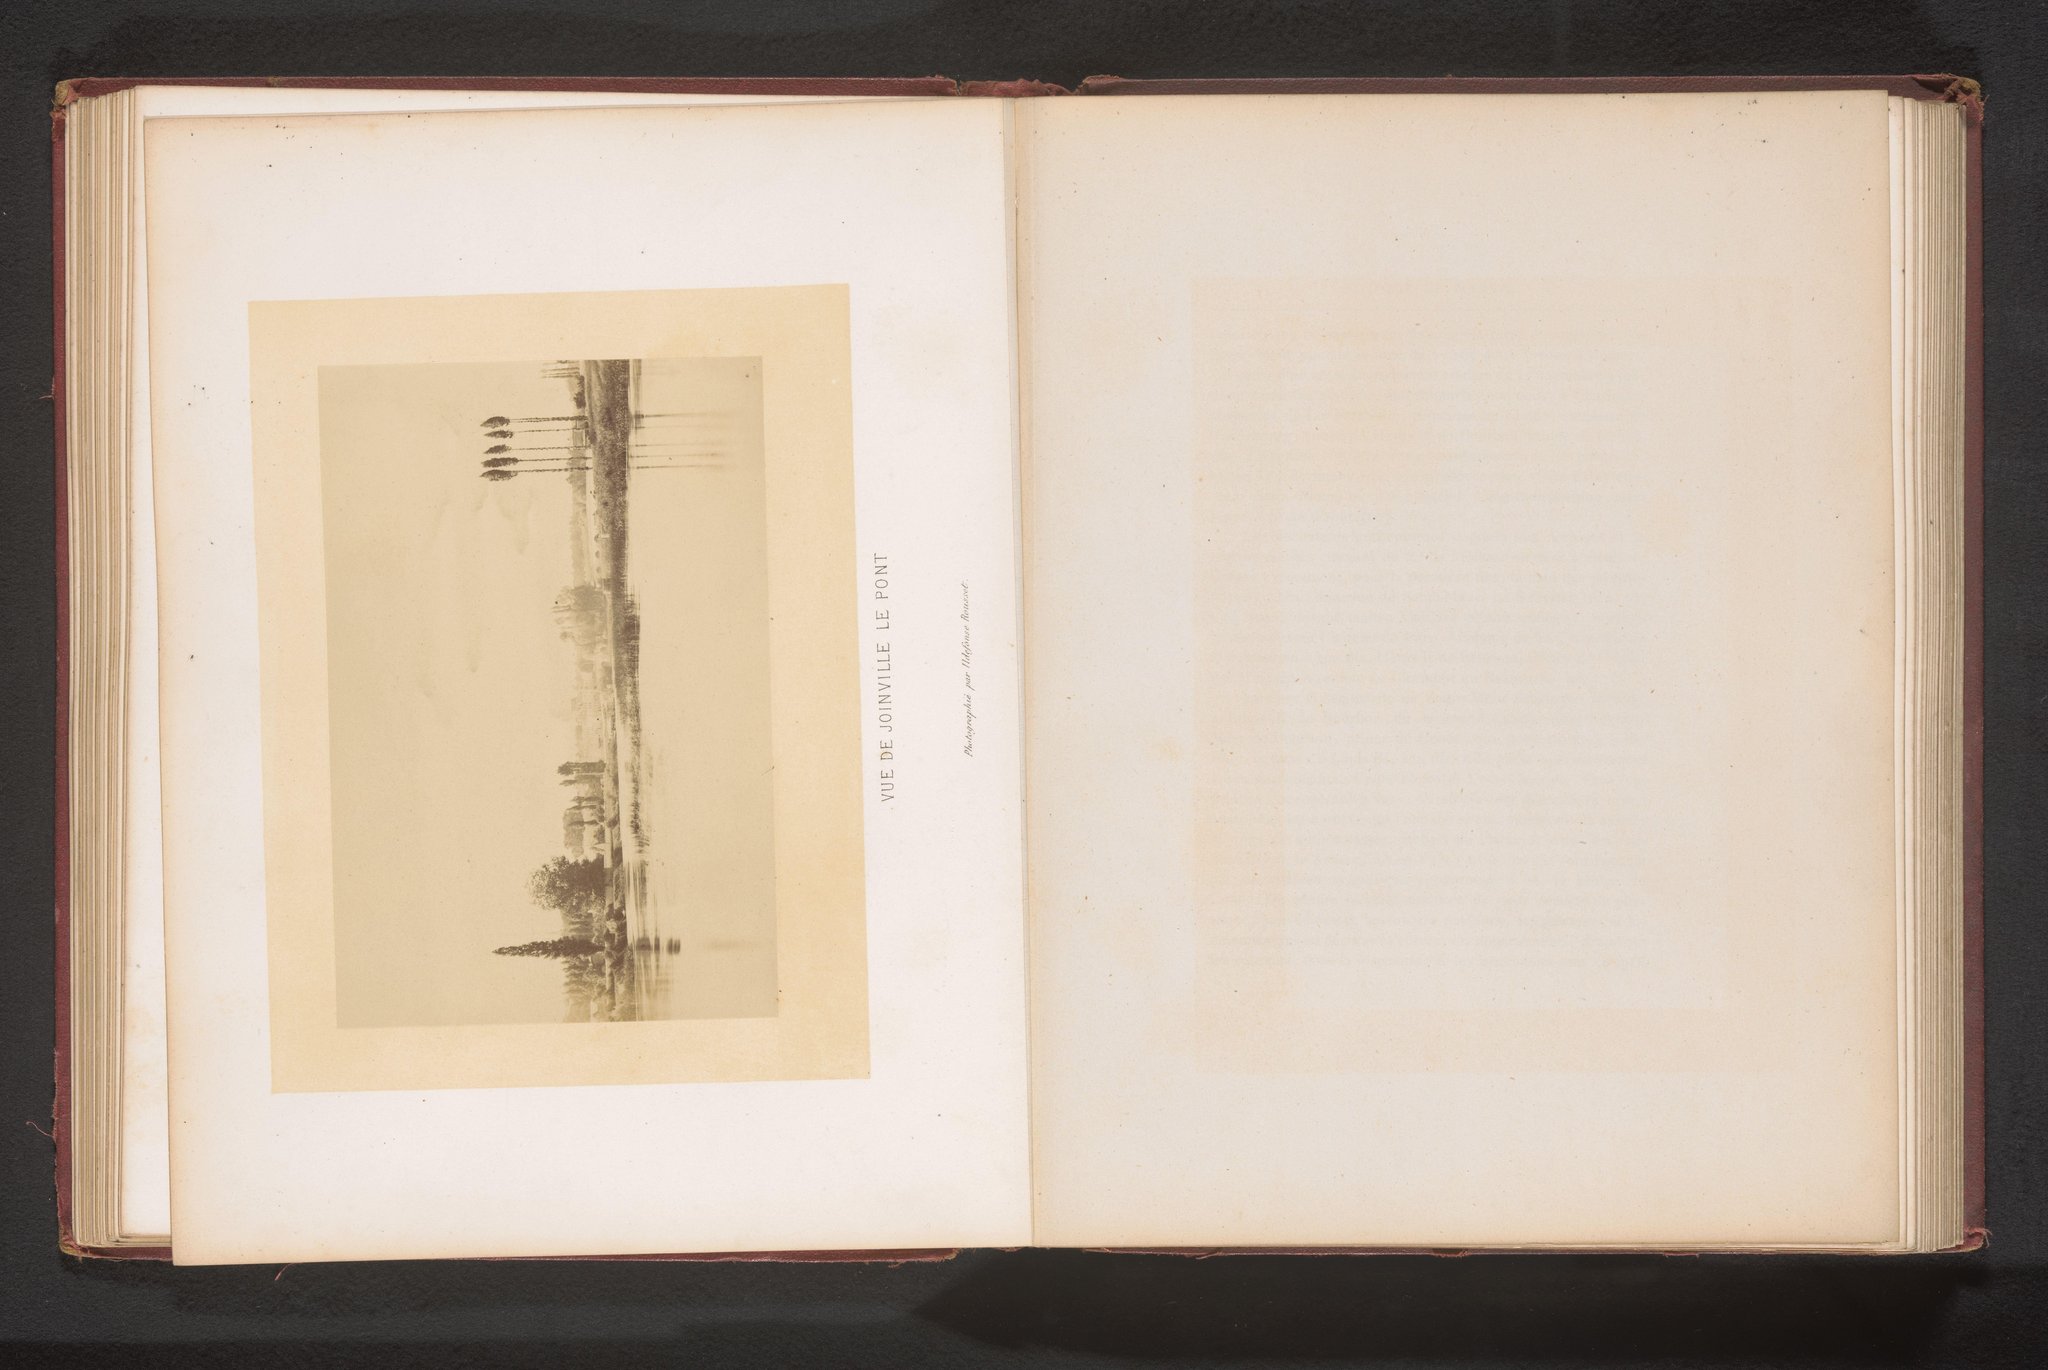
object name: page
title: Vue de Joinville le Pont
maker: ildefonse rousset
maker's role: fotograaf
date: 1860-1865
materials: photographic support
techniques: albumen print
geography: ile-de-france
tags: city-view in general; 'veduta', river